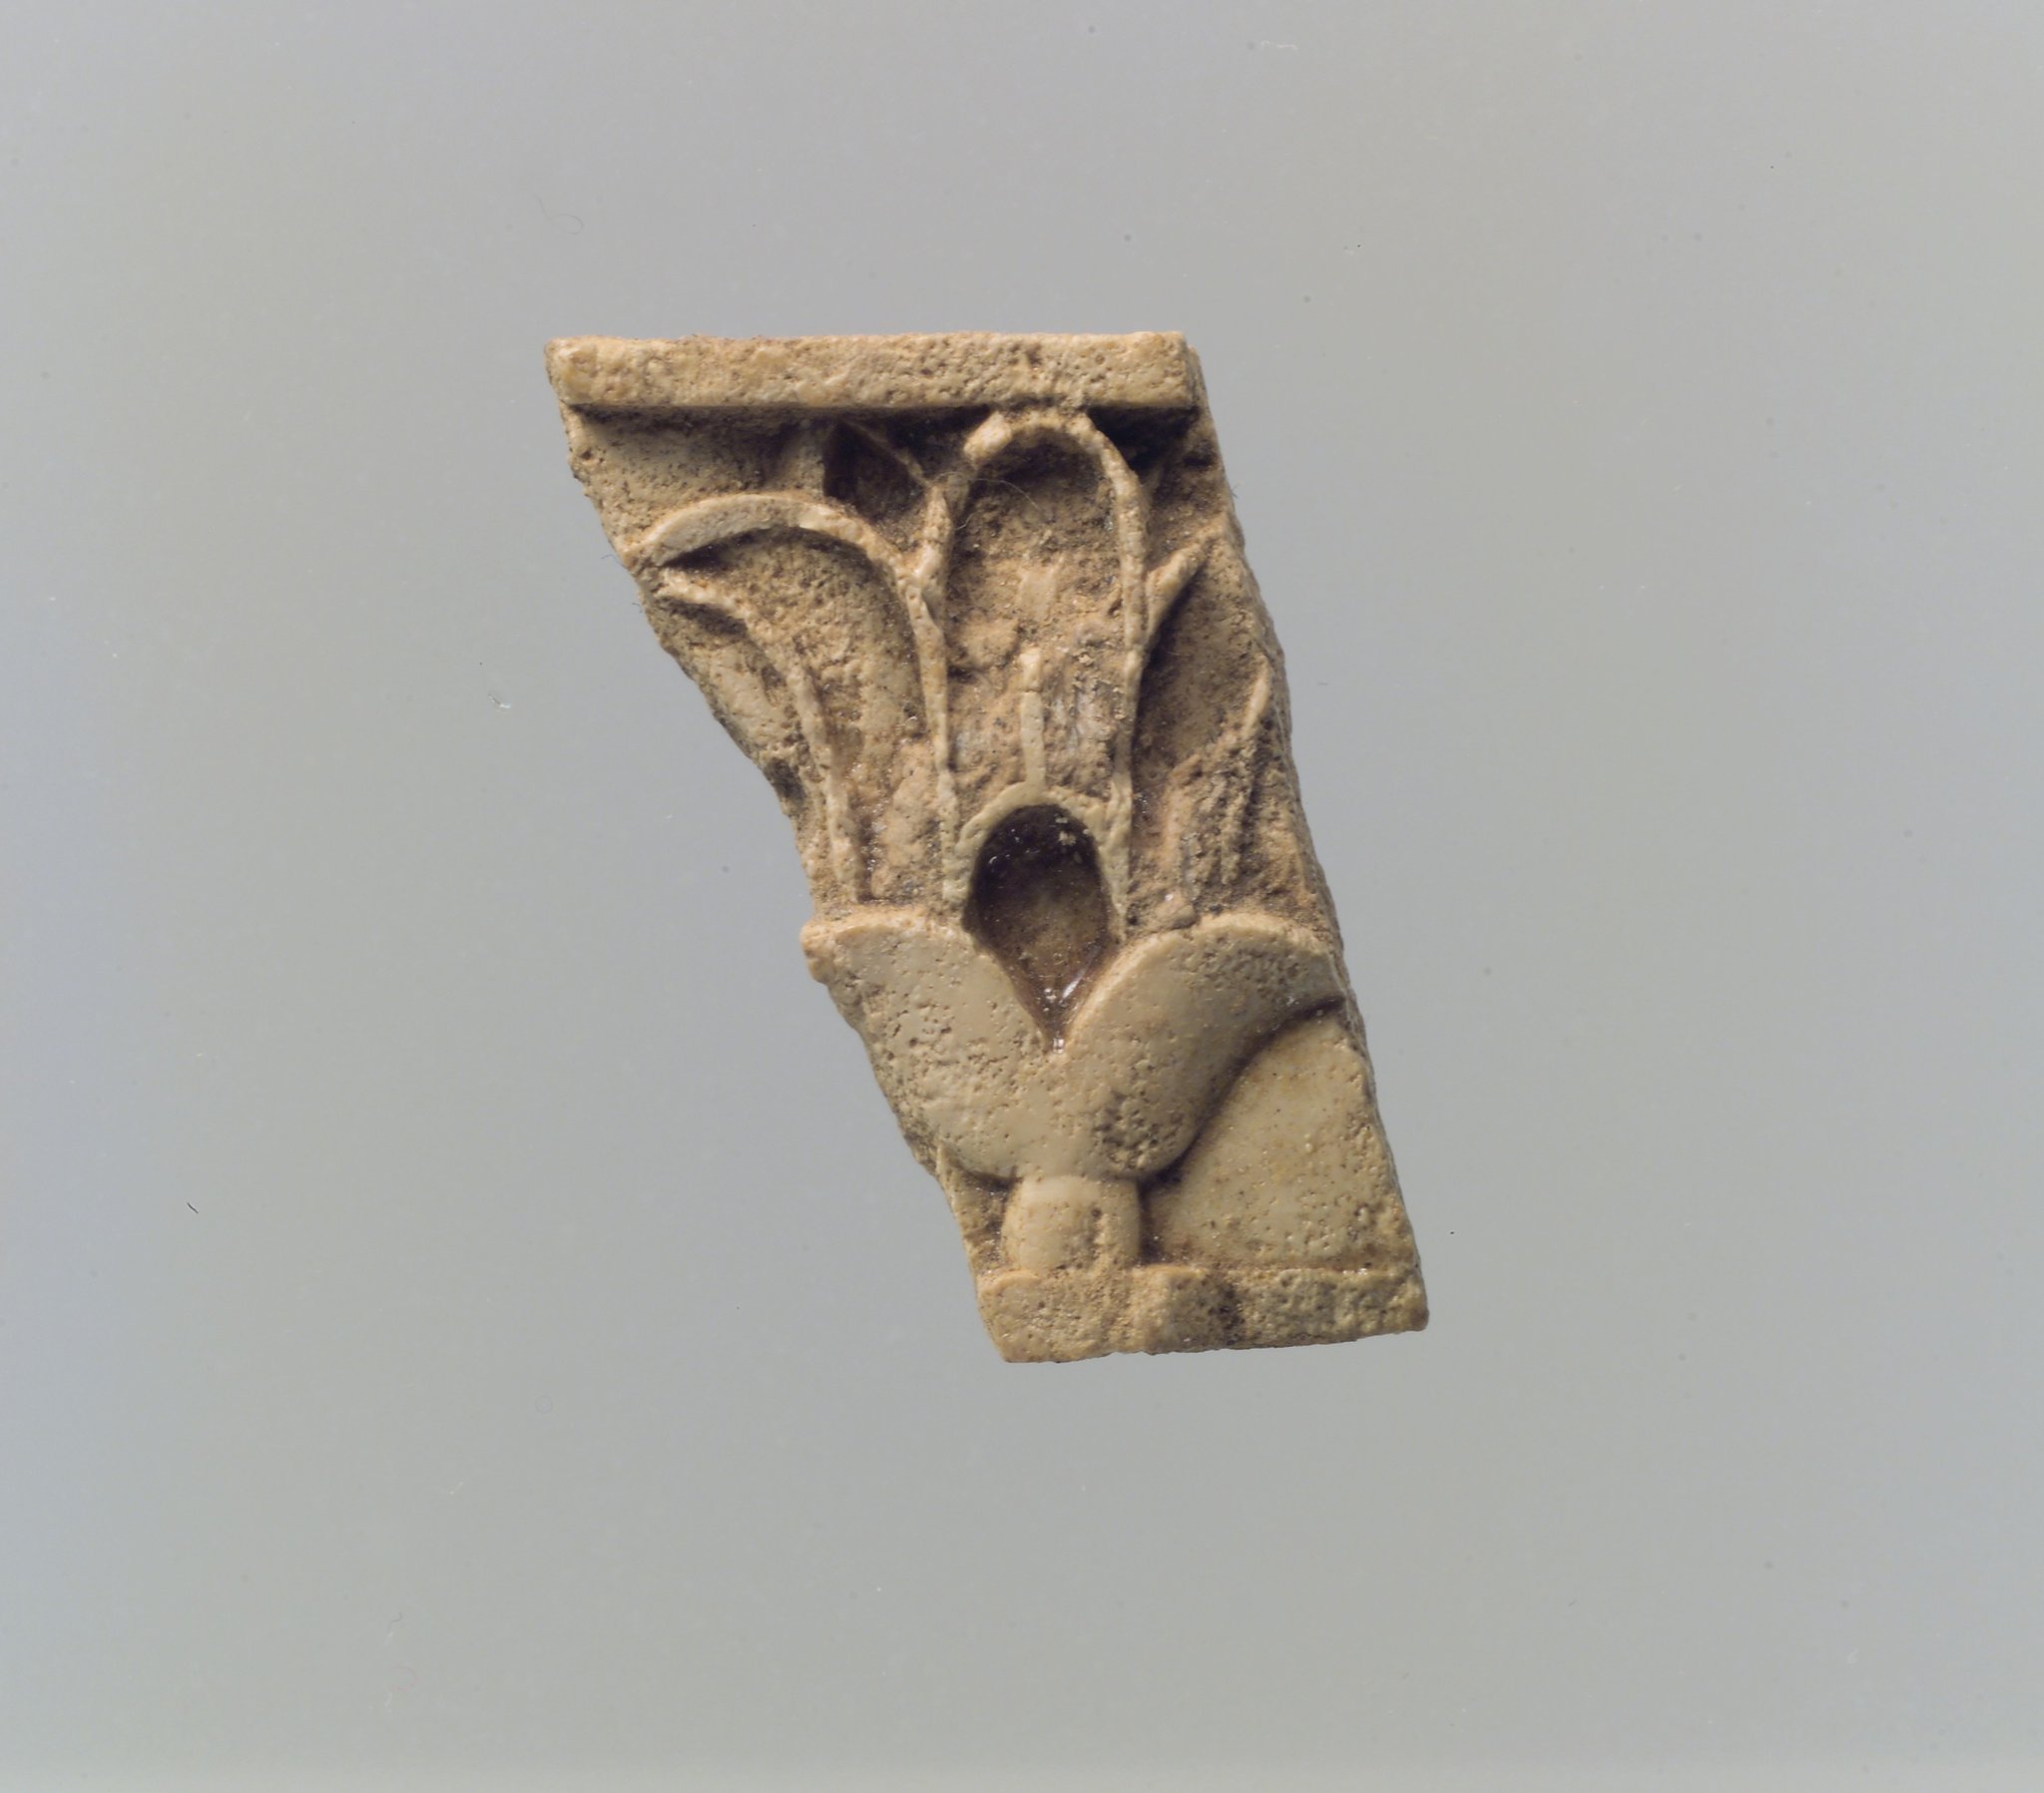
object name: relief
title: Plaque fragment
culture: assyrian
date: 800-601 BCE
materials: ivory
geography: mesopotamia